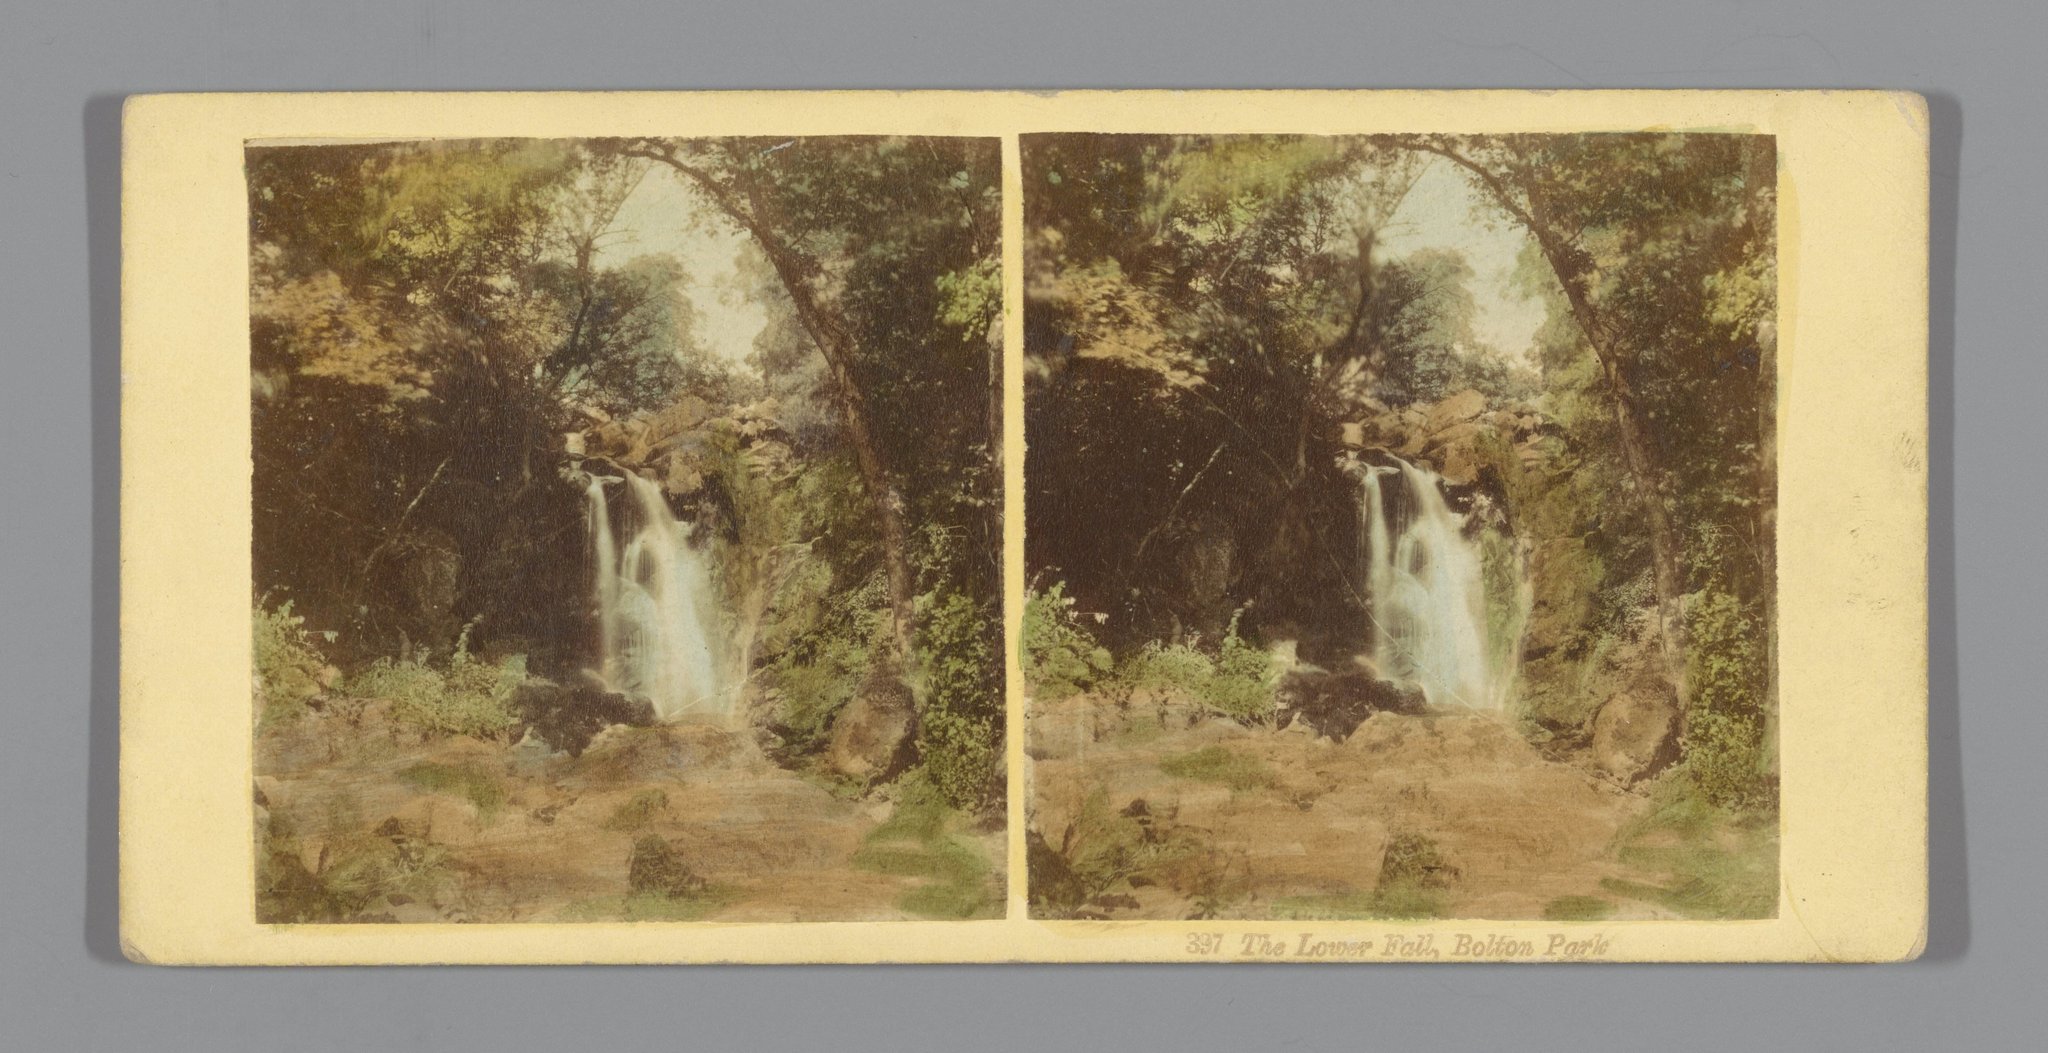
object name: stereograph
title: The Lower Fall, Bolton Park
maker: Anonymous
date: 1850-1880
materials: cardboard, photographic support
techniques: albumen print, hand coloring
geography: wharfedale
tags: waterfall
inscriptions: name, number: ‘397’